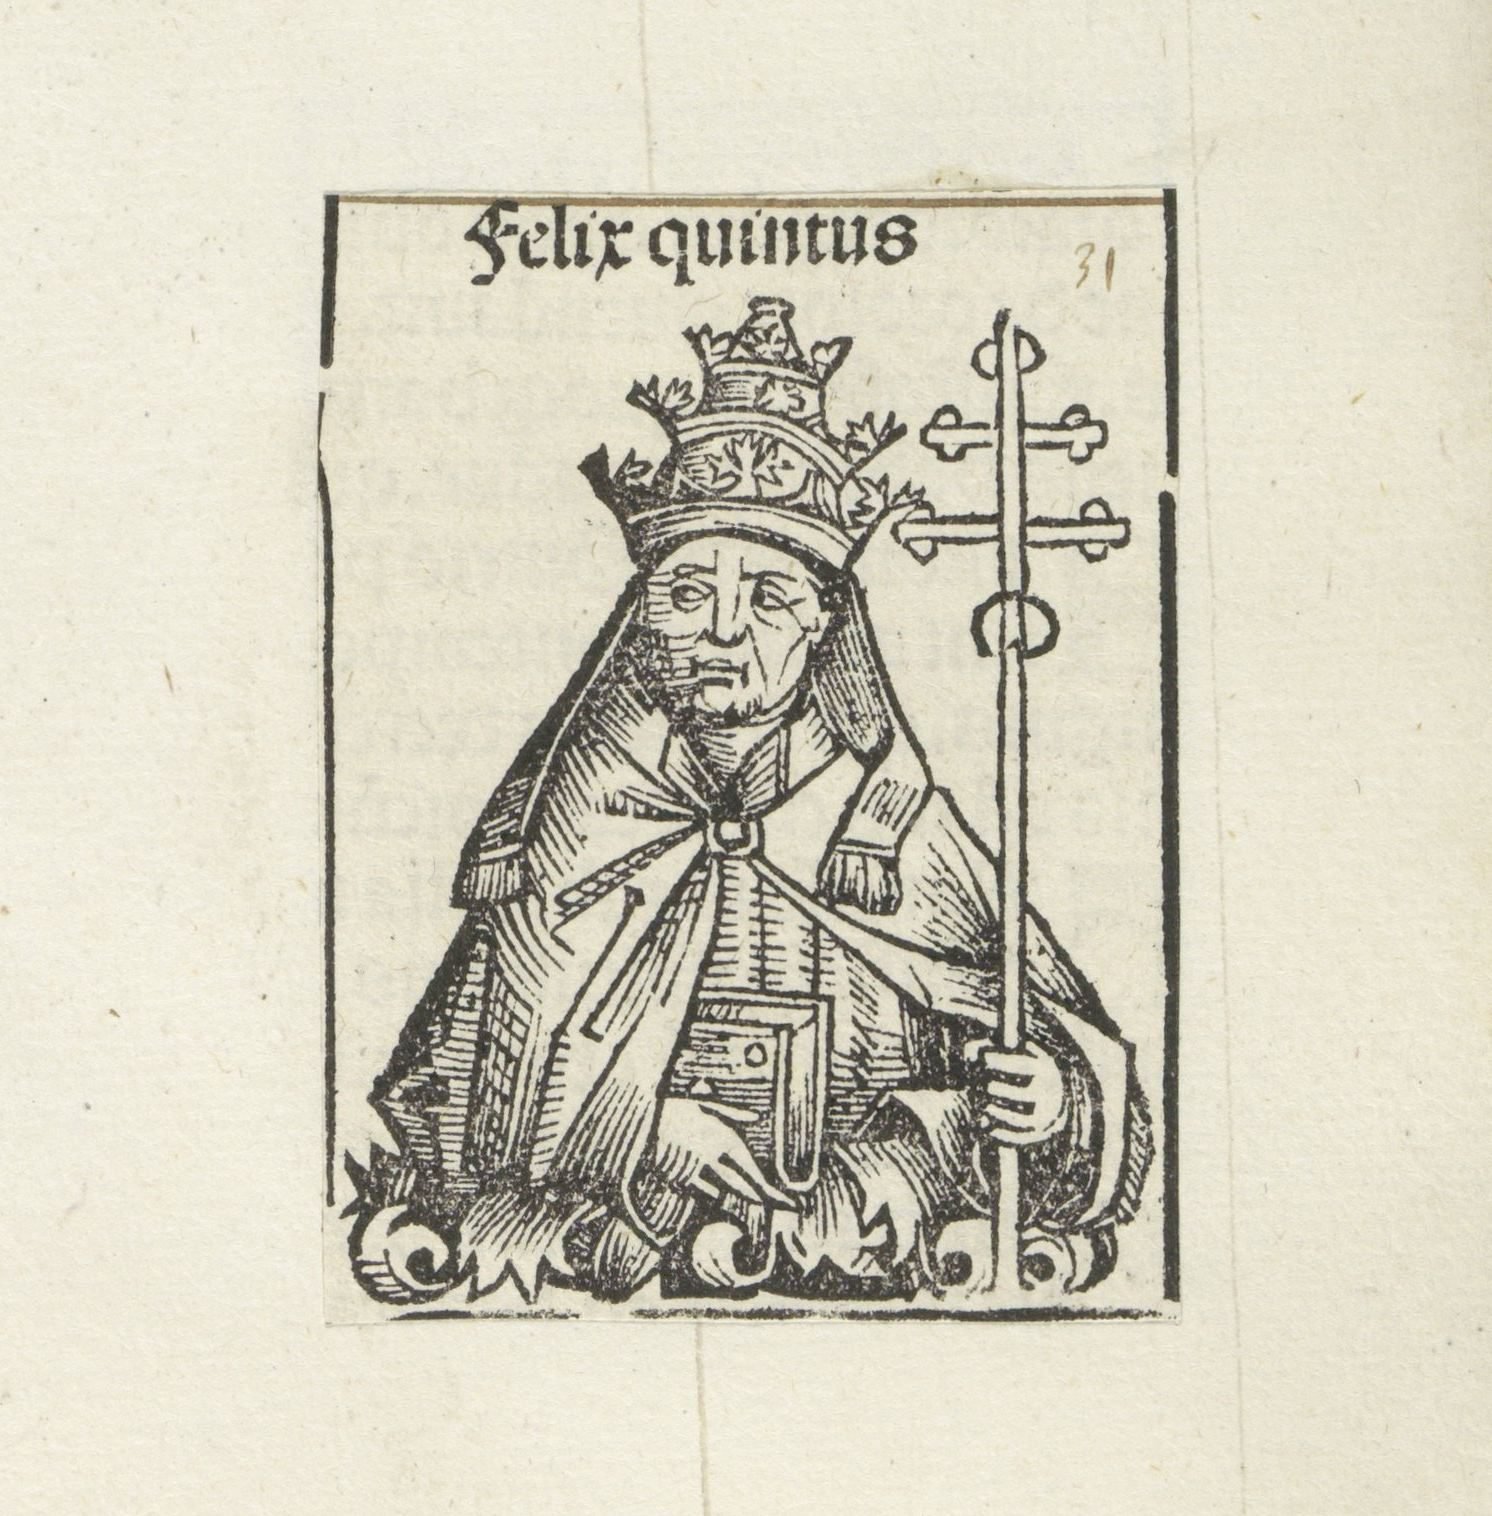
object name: album leaf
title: Eugenius quartus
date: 1493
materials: paper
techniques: letterpress printing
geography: nuremberg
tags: pope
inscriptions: inscription: ‘31’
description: Een bloemkelk met een paus. Hij draagt een tiara en heeft een bijbel en een staf met een dubbel kruis in zijn handen. De voorstelling is onderdeel van de opeenvolging pausen in de Liber Chronicarum. De tekst identificeert de man als tegenpaus Felix V. De prent maakt deel uit van een album.